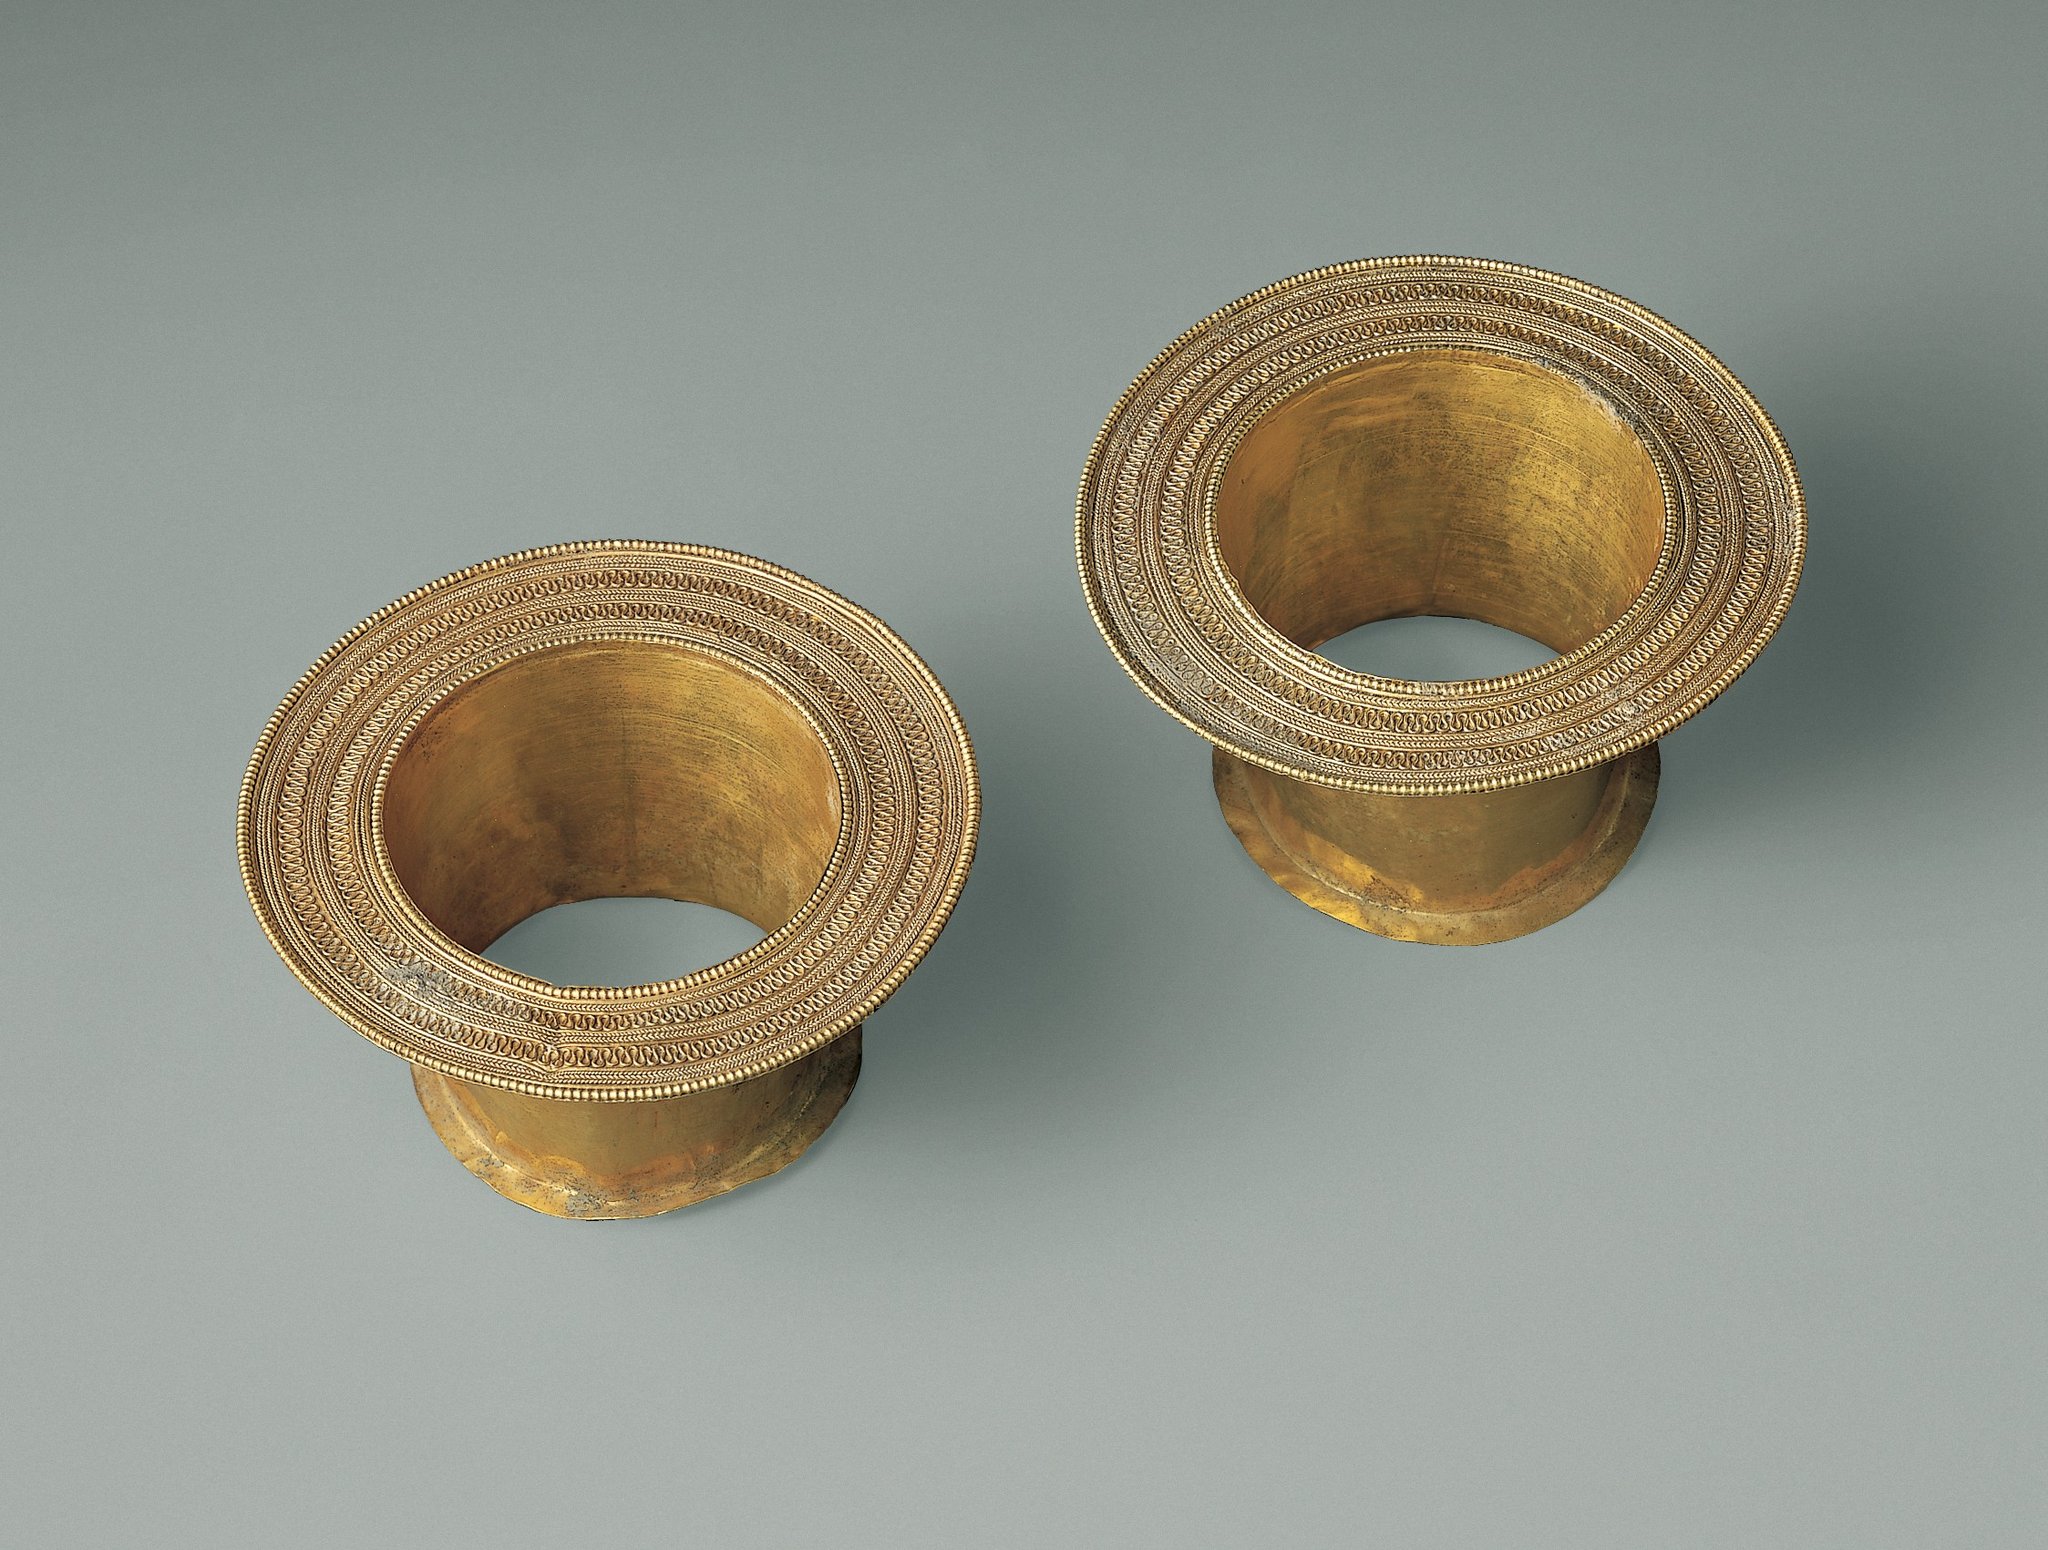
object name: roundel, pair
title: Pair of gold roundels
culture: greek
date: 500-301 BCE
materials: gold